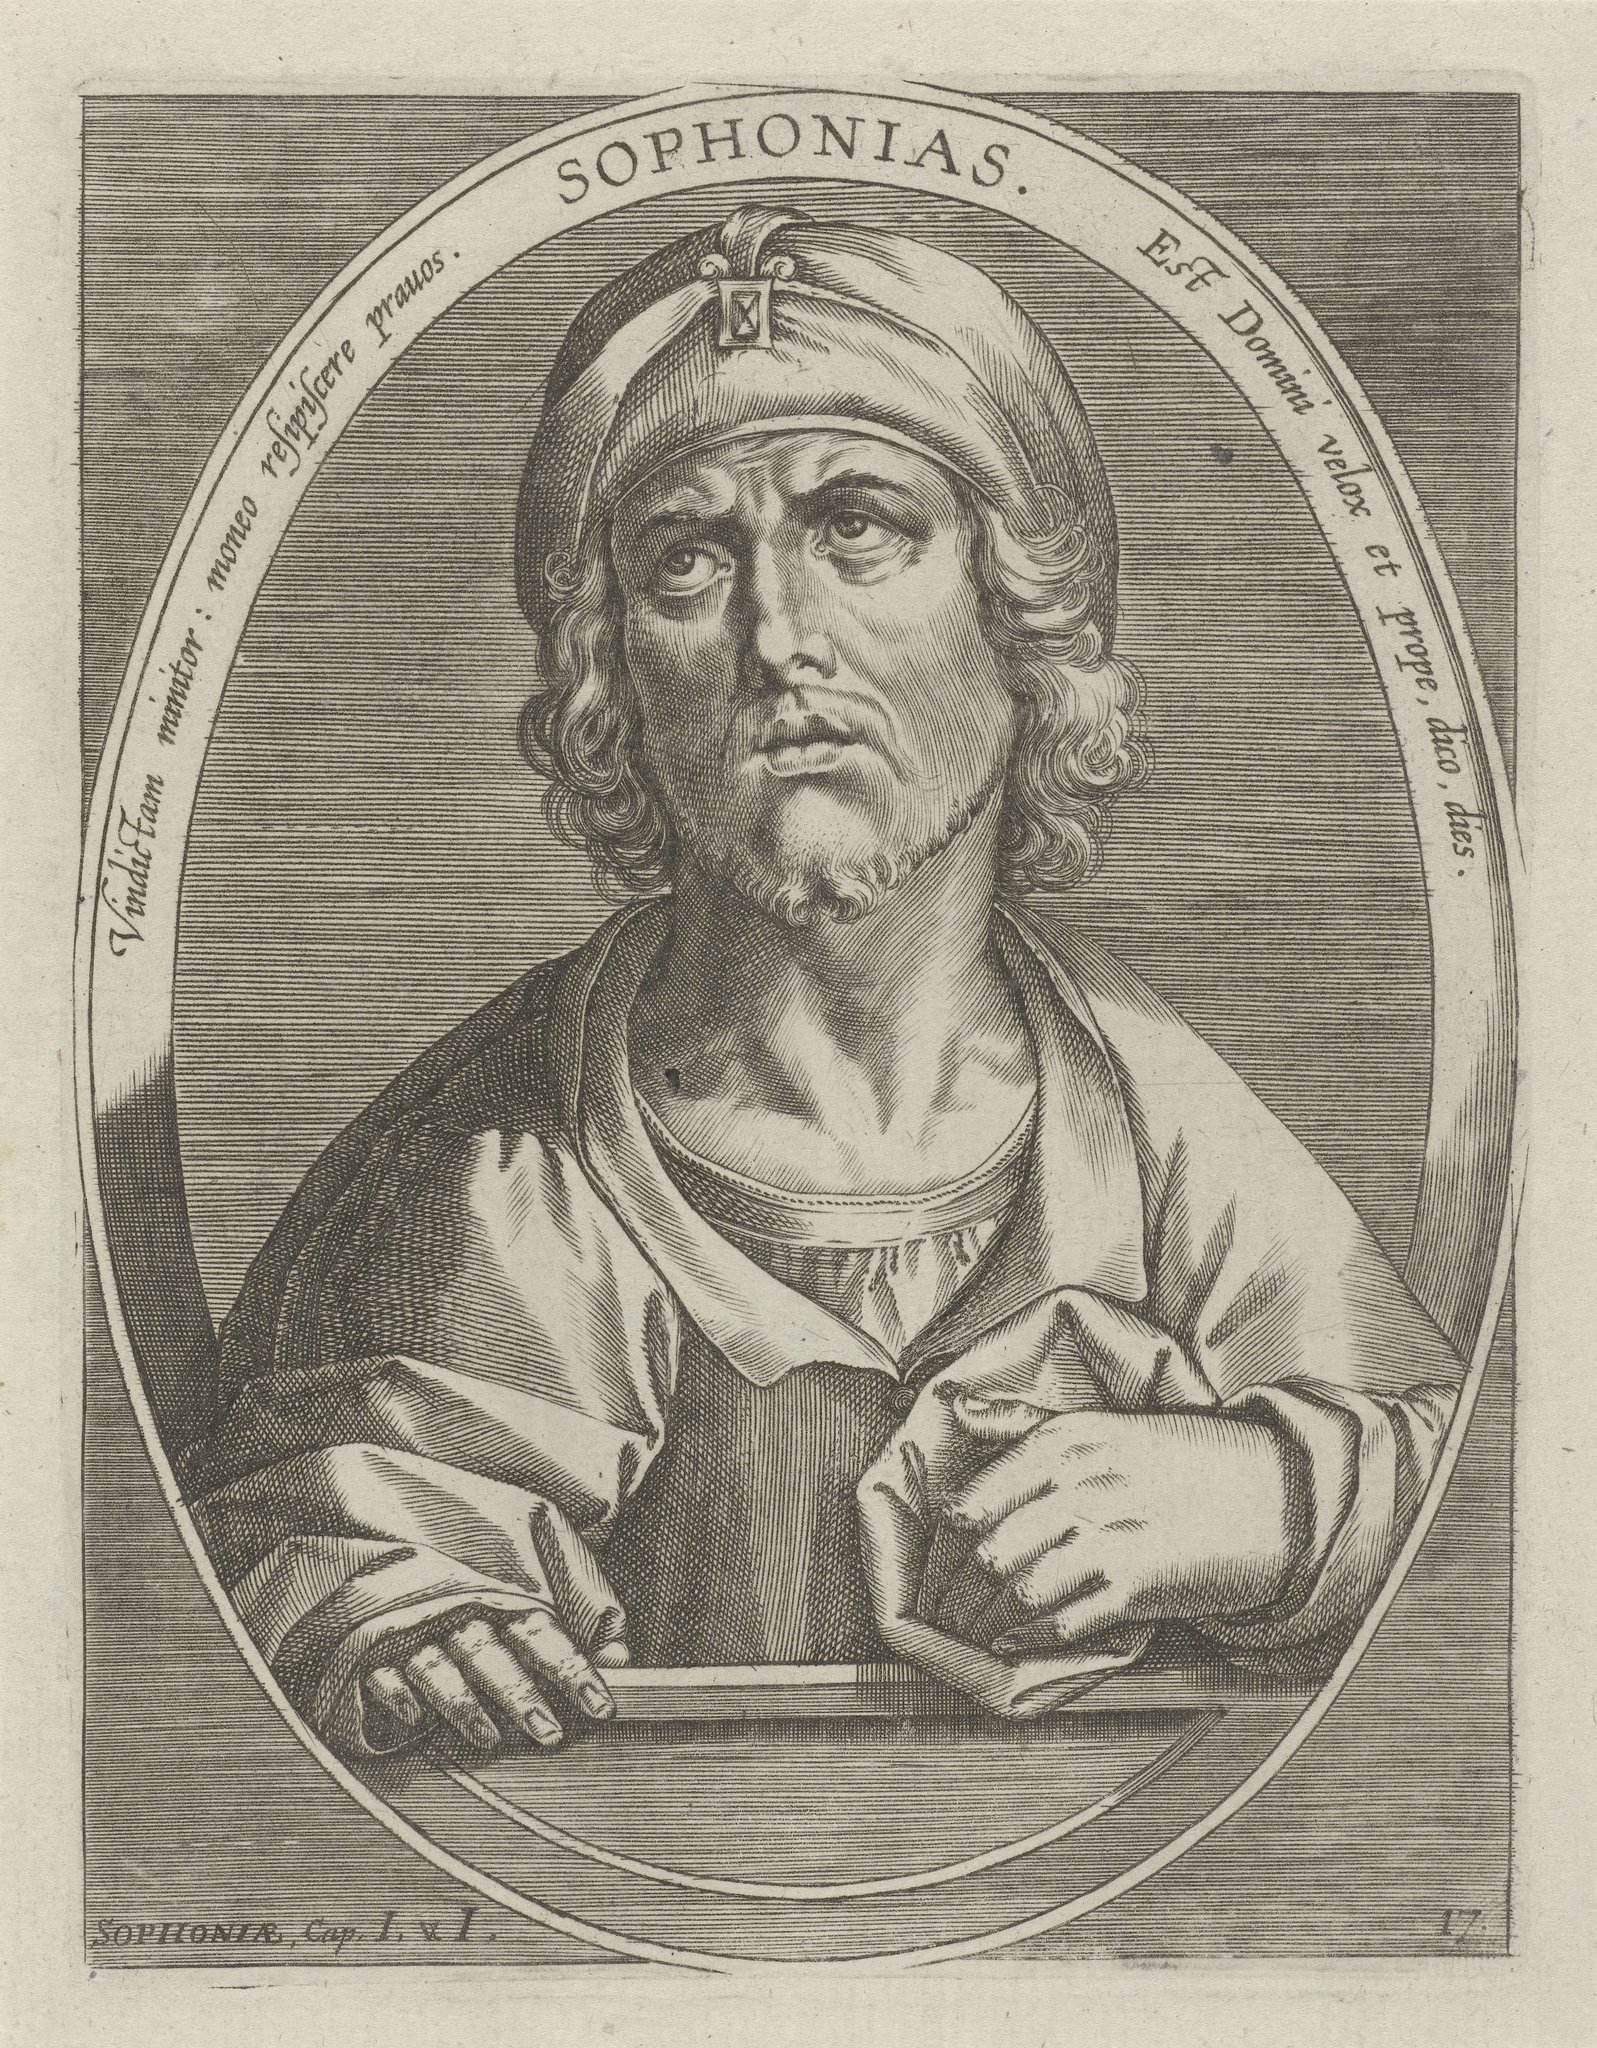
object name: print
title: Icones Prophetarum Veteris Testamenti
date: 1613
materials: paper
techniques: engraving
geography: antwerp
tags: the twelve minor prophets (not in biblical context): hosea, joel, amos, obadiah, jonah, micah, nahum, habakkuk, zephaniah, haggai, zechariah, malachi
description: De profeet Zefanja, in ovaal met Latijns randschrift. Zefanja draagt een tulband.